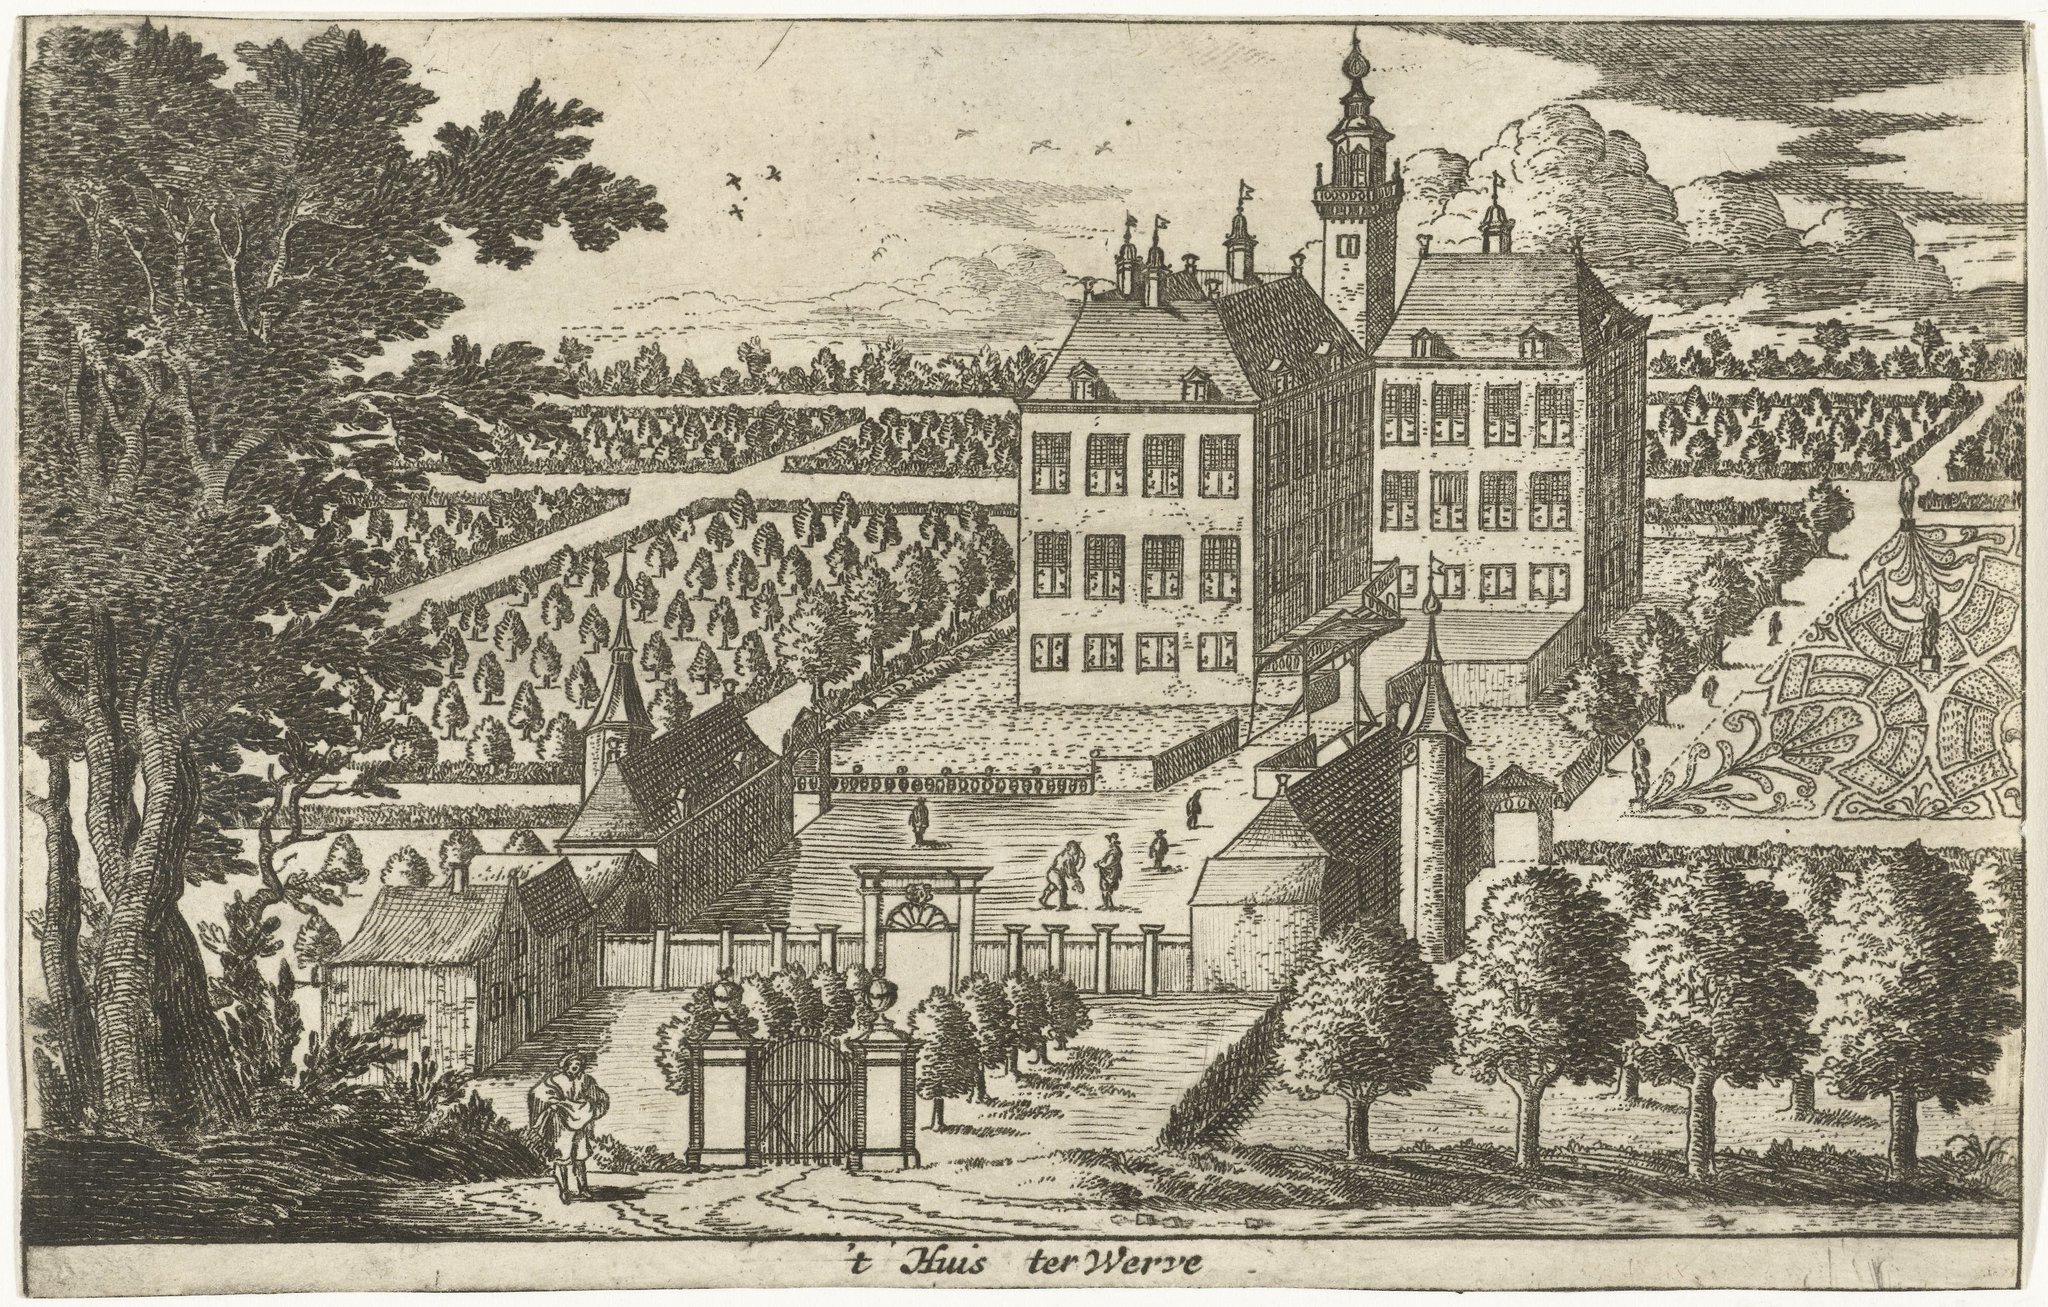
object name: print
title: Huis te Werve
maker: cornelis elandts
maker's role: draughtsman, painter, print maker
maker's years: 1641-1687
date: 1663-1670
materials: paper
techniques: etching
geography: the hague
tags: castle, huis te werve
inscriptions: collector's mark: Lugt 2228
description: Gezicht op een landgoed met het landhuis te midden van formele tuinen. Op de voorgrond staat een man tussen de toegangspoort en een hoge boompartij.